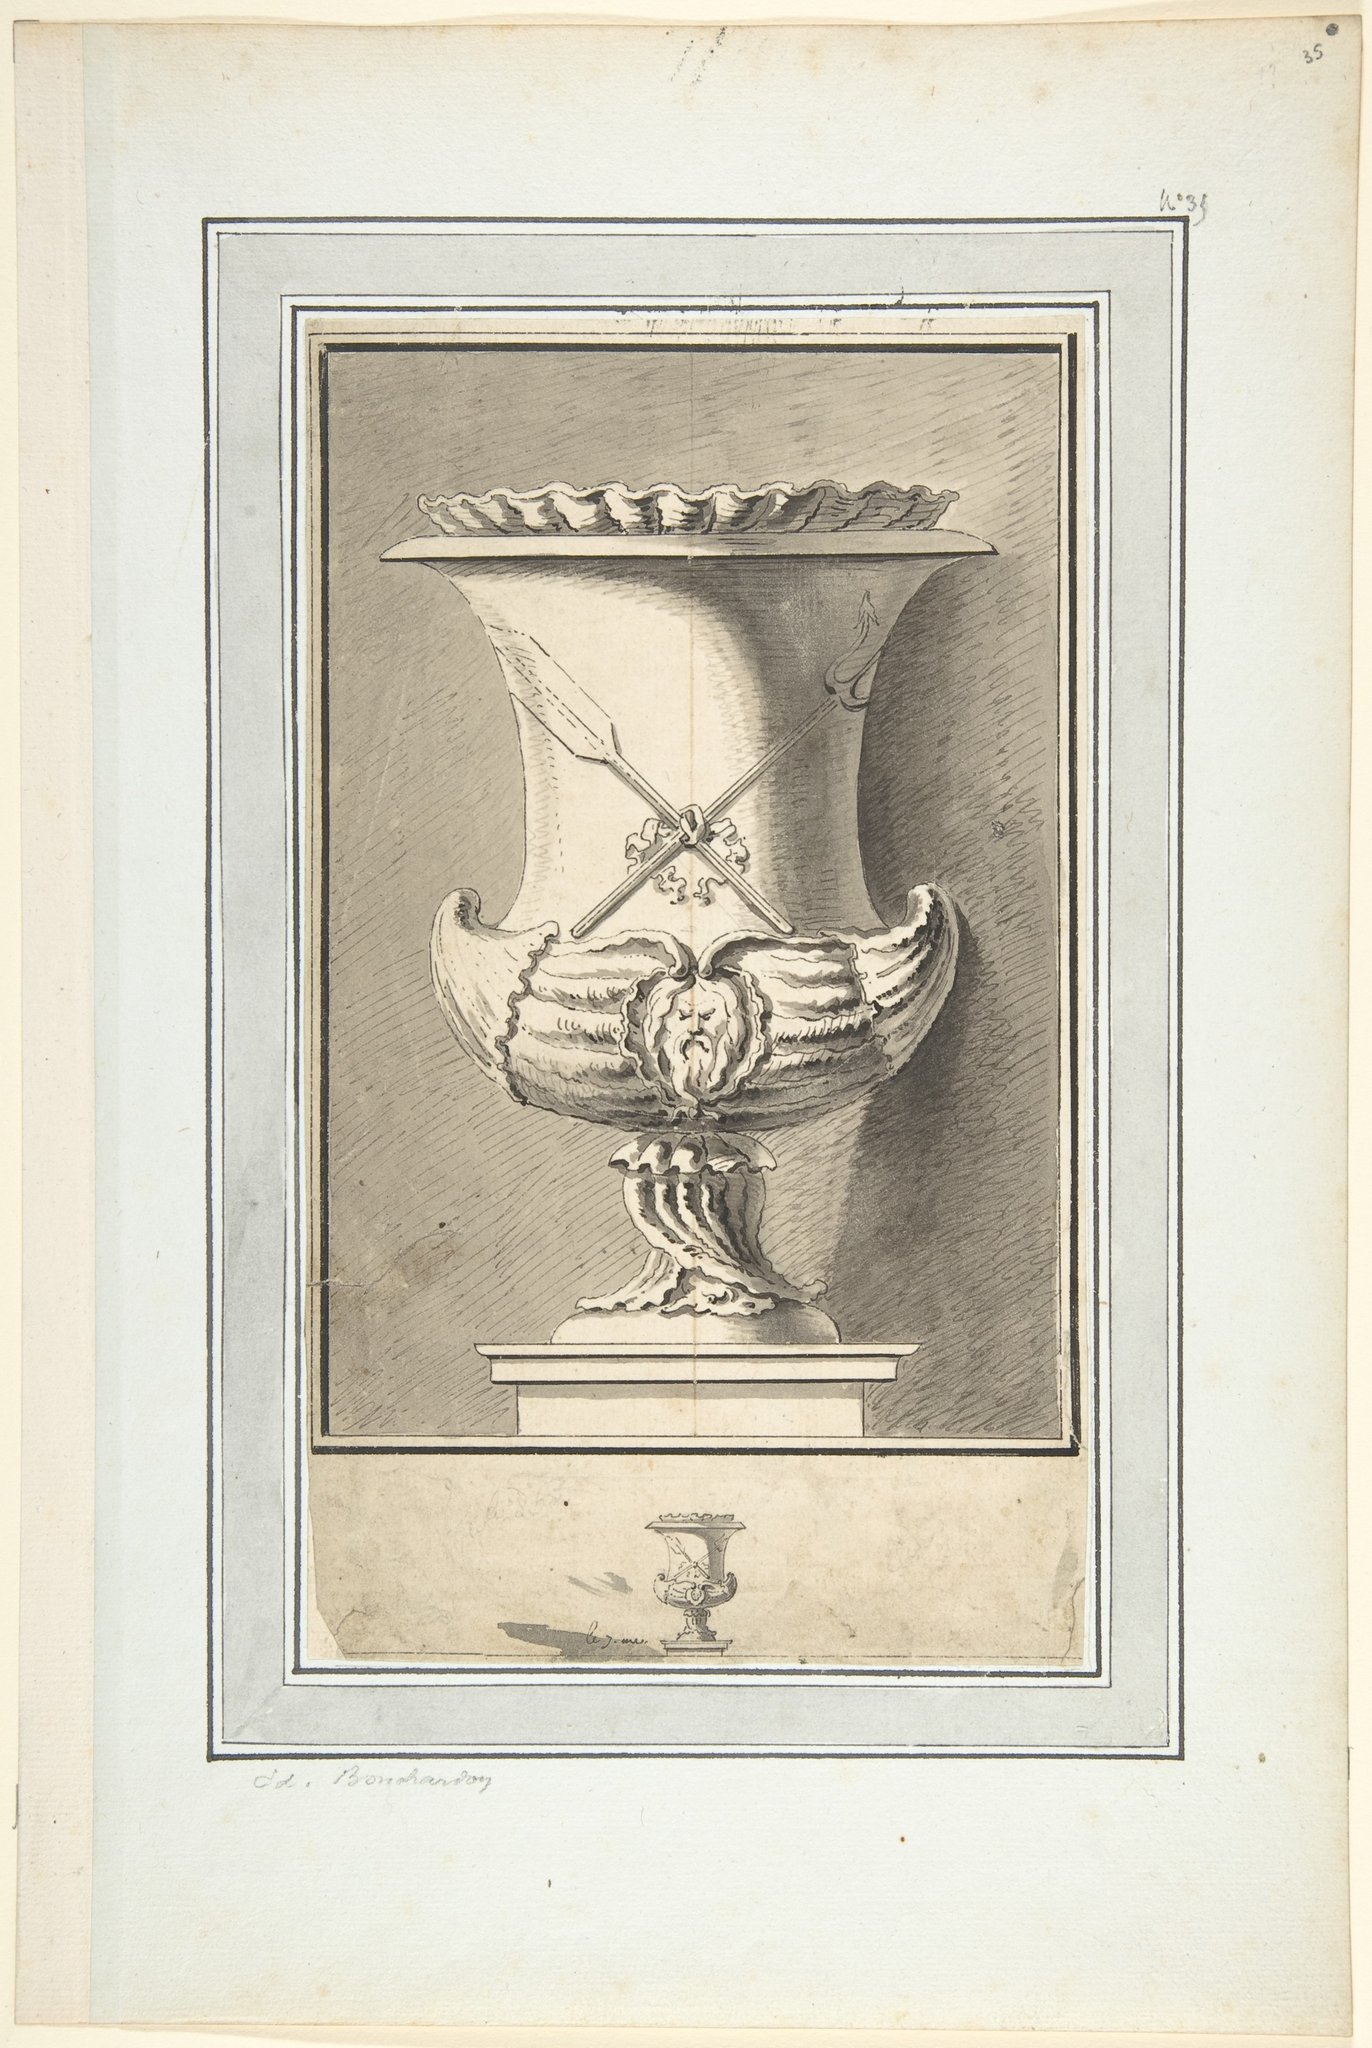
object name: drawing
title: Study for Plate 7 of Bouchardon's "Premier livre de vases"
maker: edme bouchardon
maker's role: artist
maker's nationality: french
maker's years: 1698-1762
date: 1701-1800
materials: chalk, ink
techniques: brush, pen, wash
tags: weapons,faces,vases